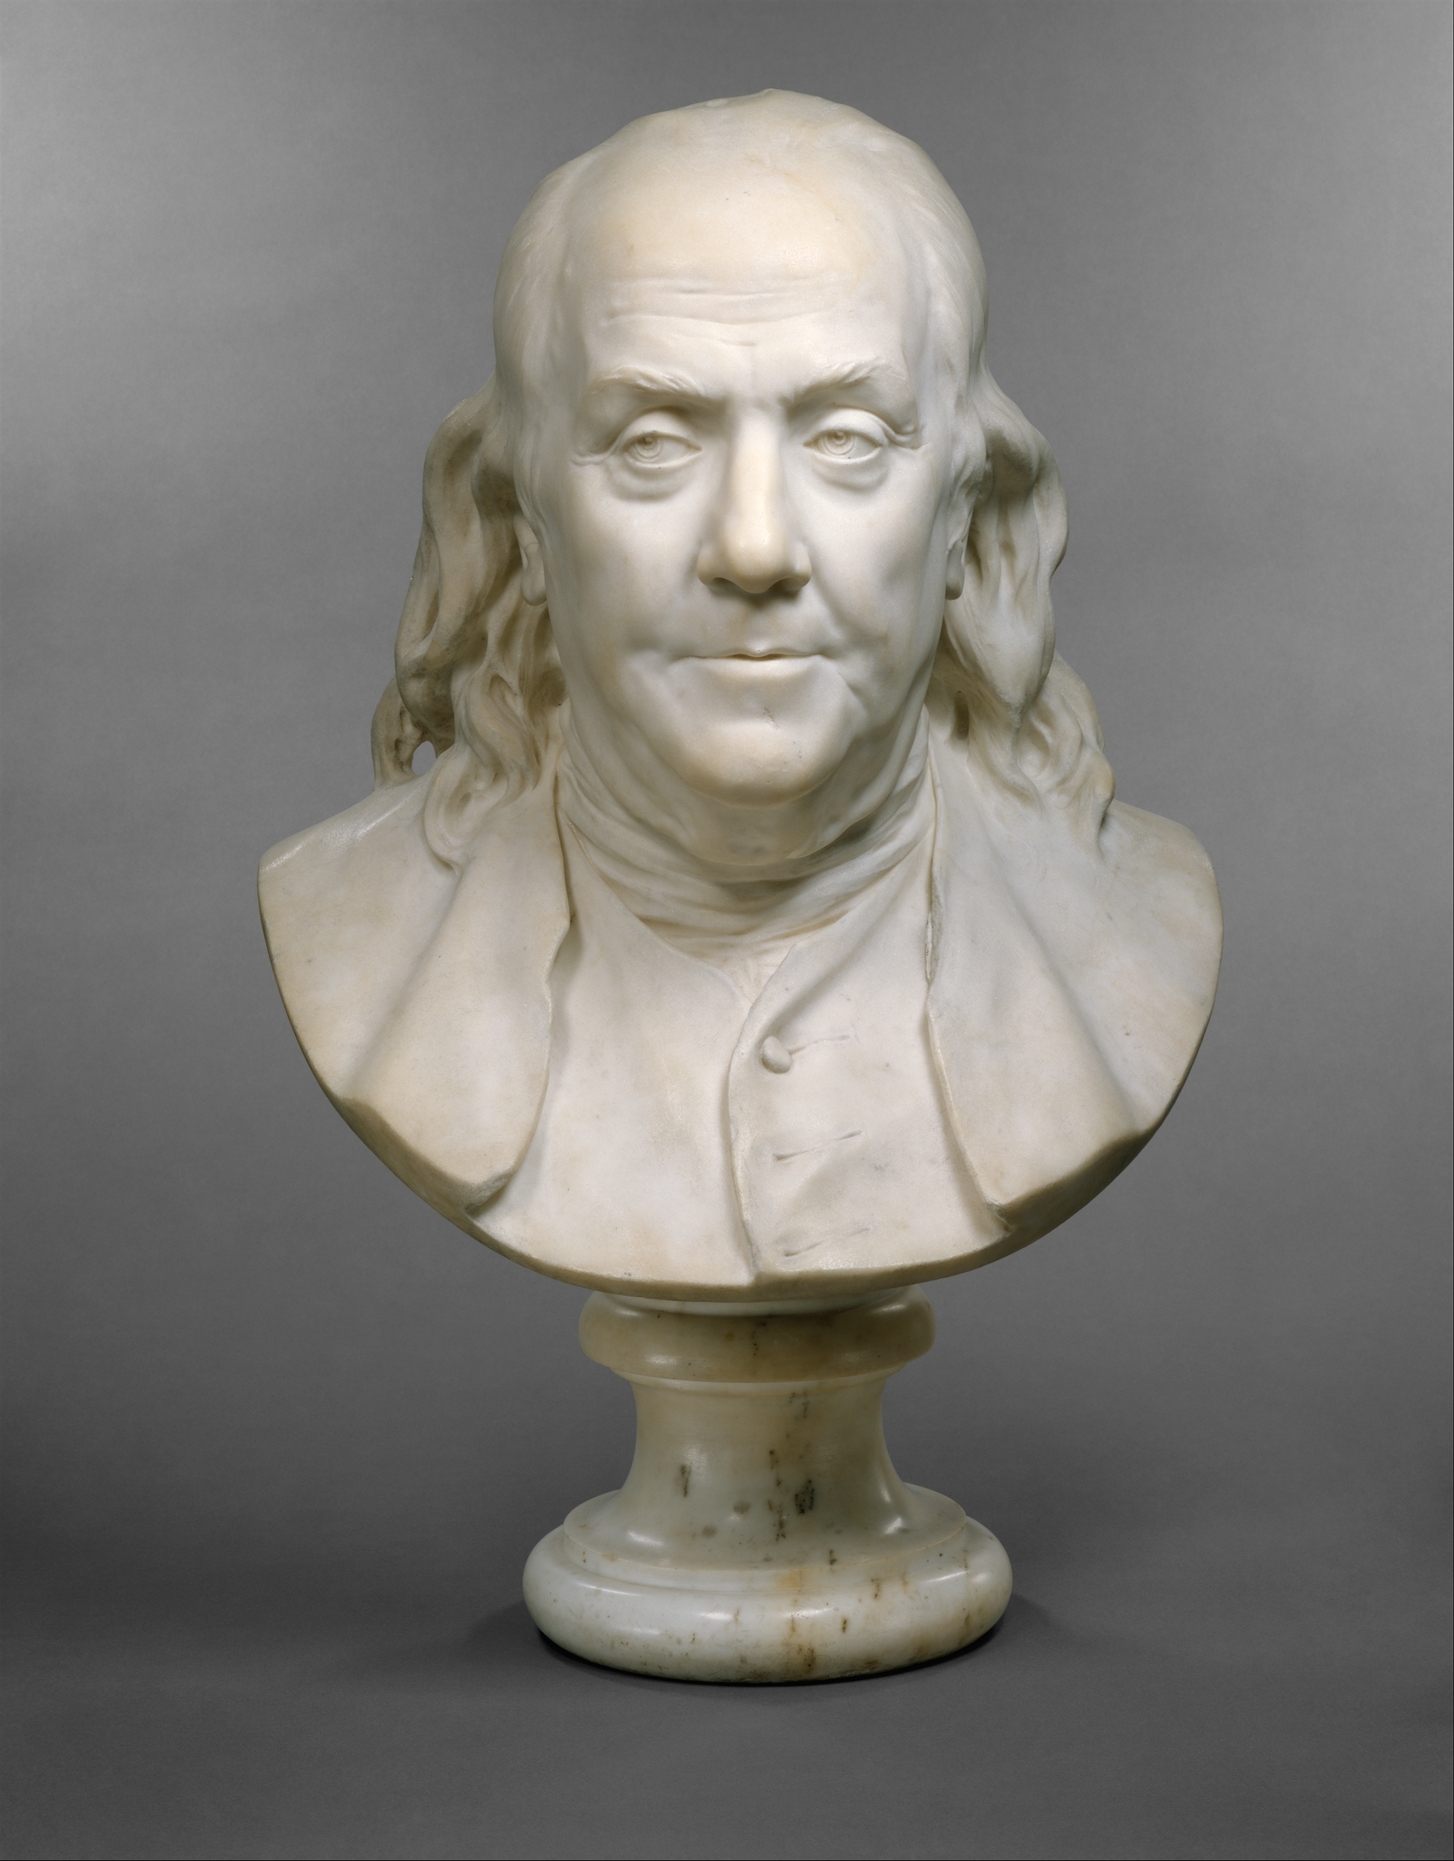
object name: bust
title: Benjamin Franklin (1706–1790)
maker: jean antoine houdon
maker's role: artist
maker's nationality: french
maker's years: 1741-1828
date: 1778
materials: marble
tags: benjamin franklin,men,portraits